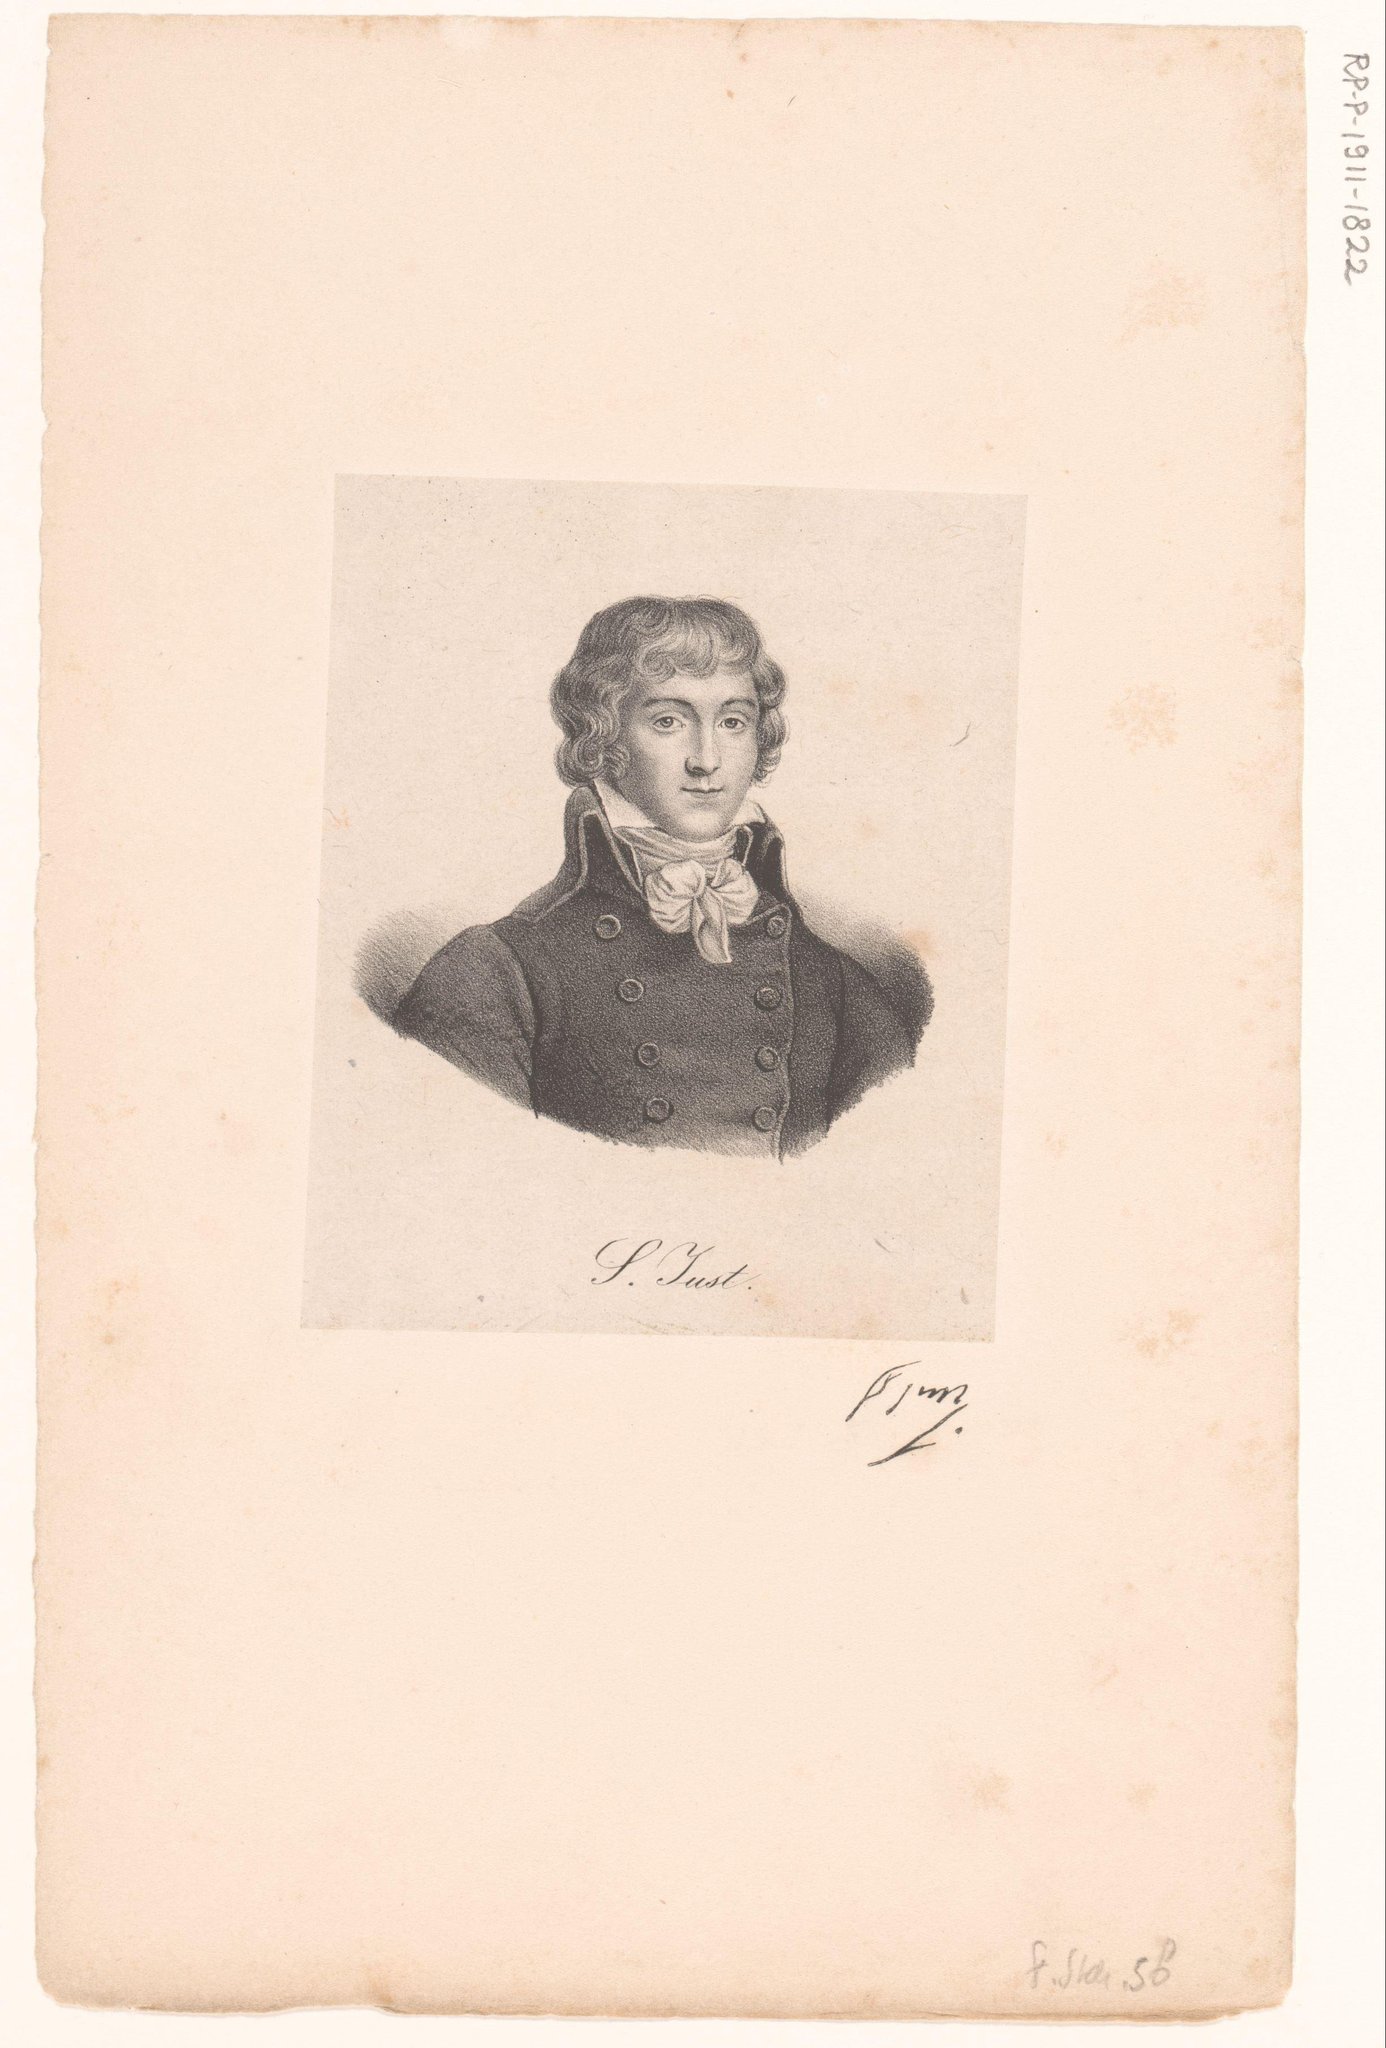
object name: print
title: S. Just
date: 1818-1842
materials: paper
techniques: lithograph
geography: paris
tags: paris, politician, historical persons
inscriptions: collector's mark: Lugt 2228a